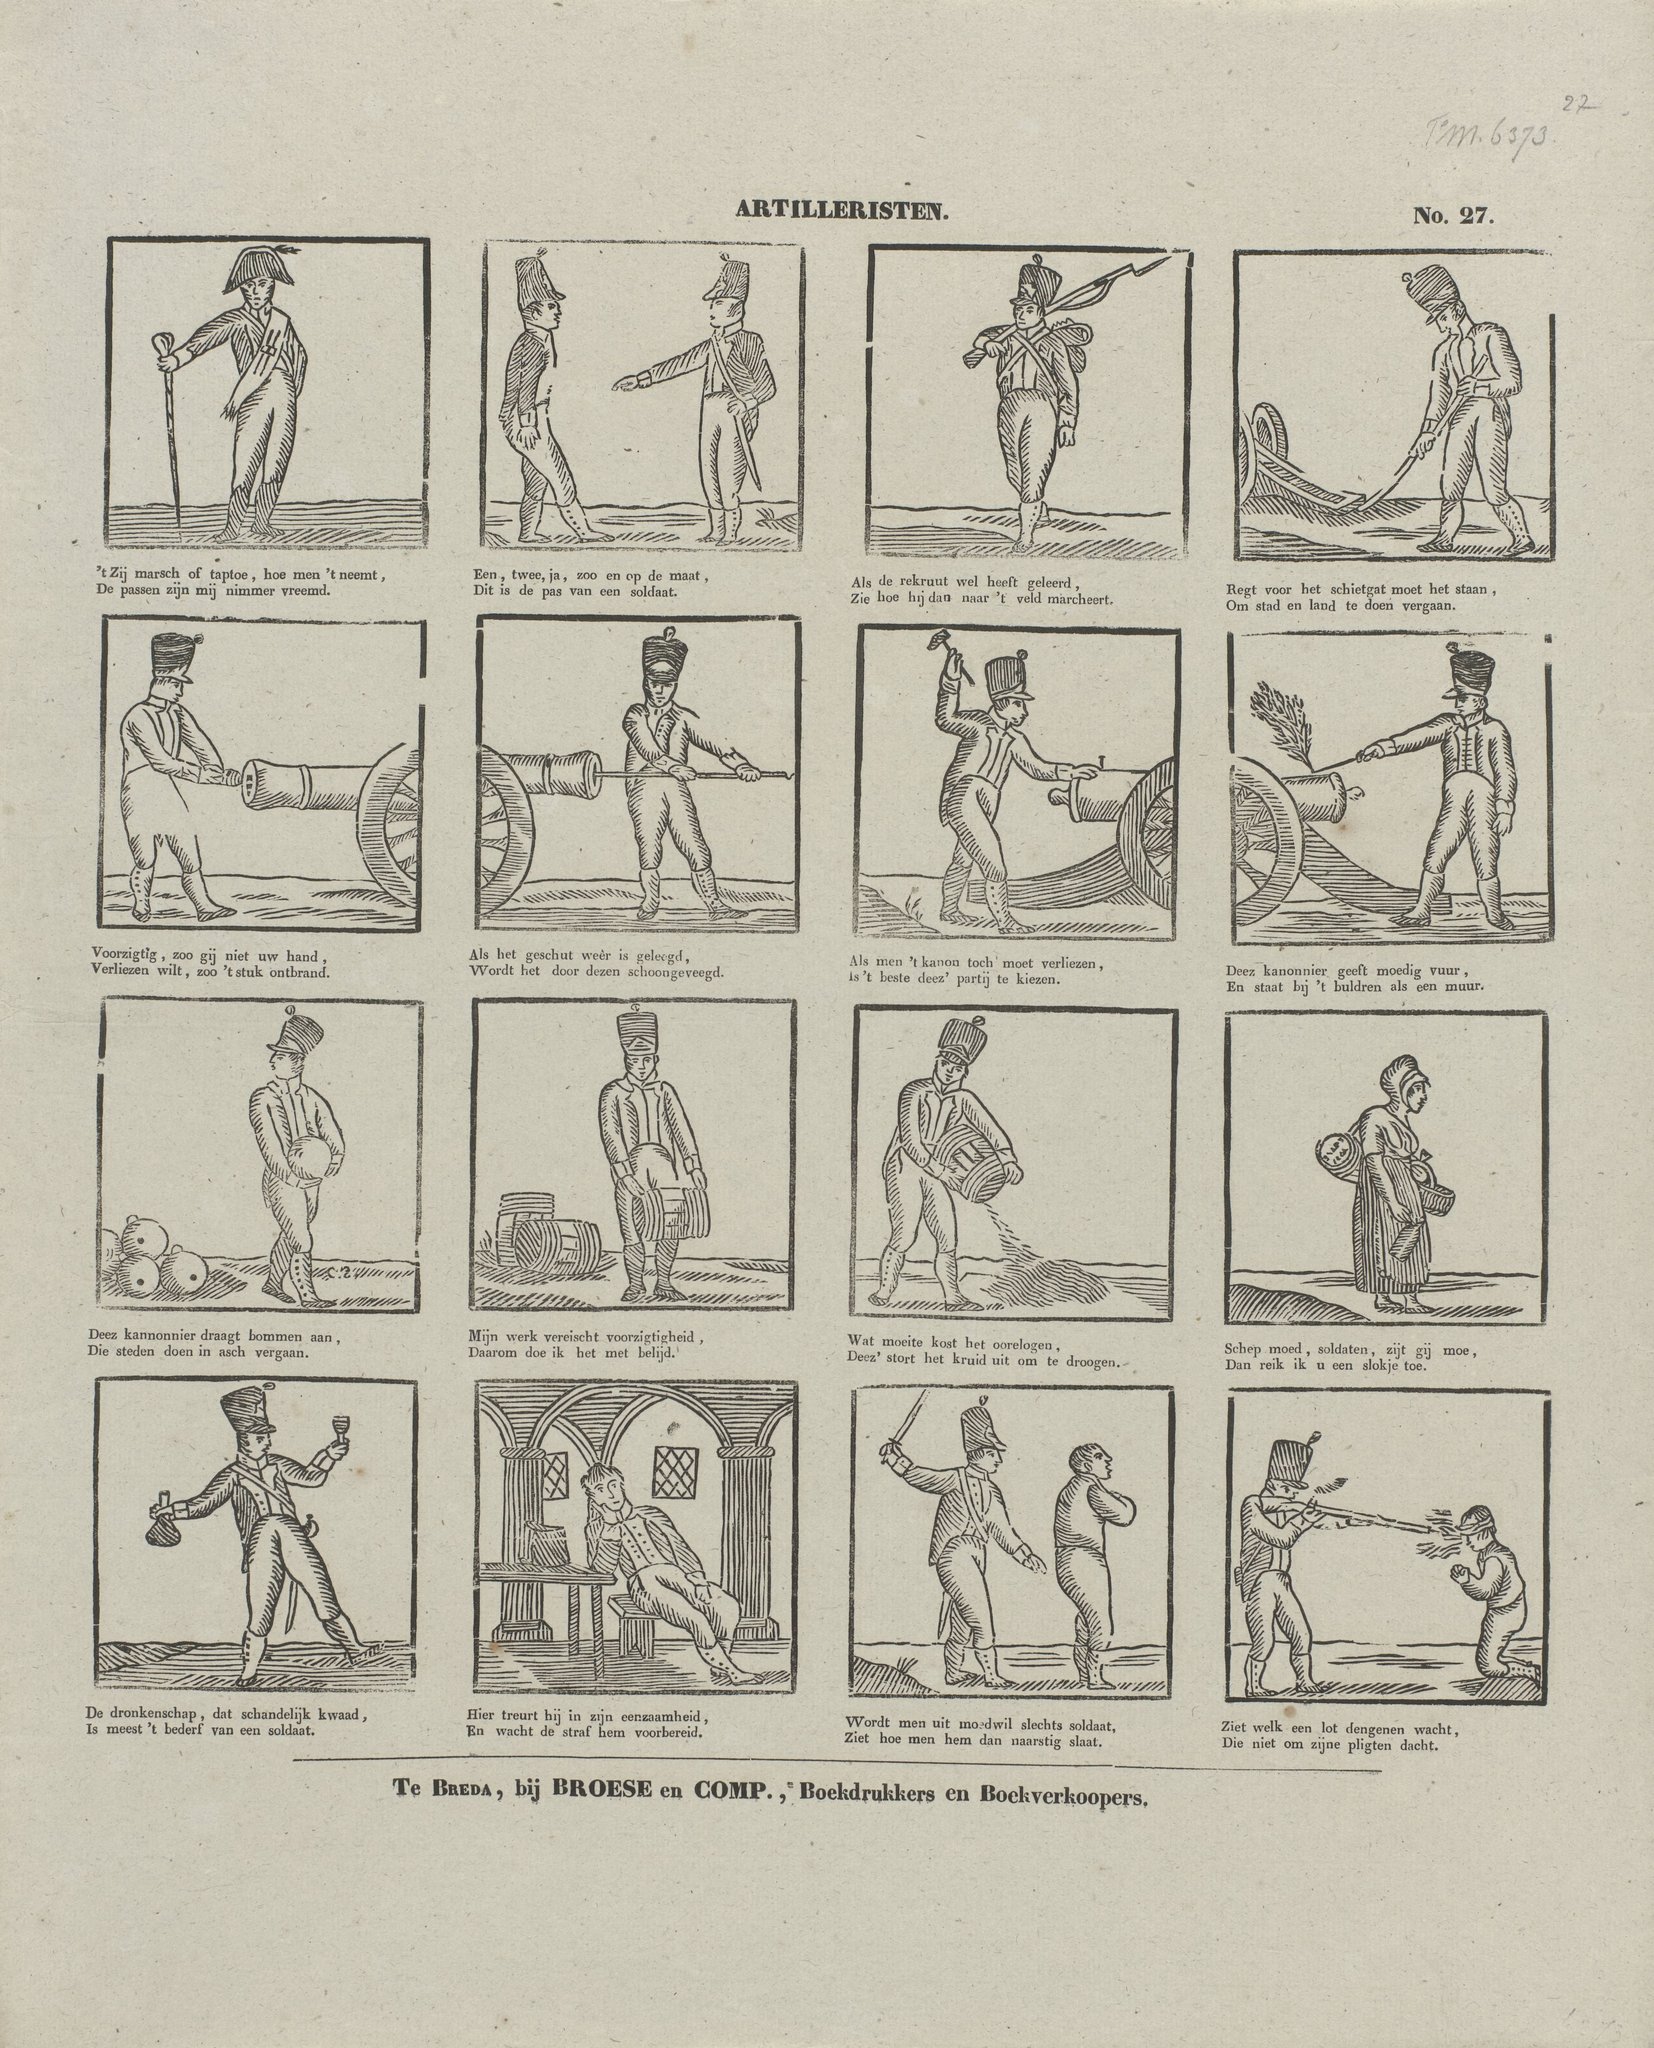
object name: print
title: Artilleristen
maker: Anonymous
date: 1828-1853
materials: paper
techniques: letterpress printing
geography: breda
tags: weapons, the soldier; the soldier's life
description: Blad met 16 voorstellingen van militairen met kanonnen, kruid en zwaarden. Onder elke afbeelding een tweeregelig vers. Genummerd rechtsboven: No. 27